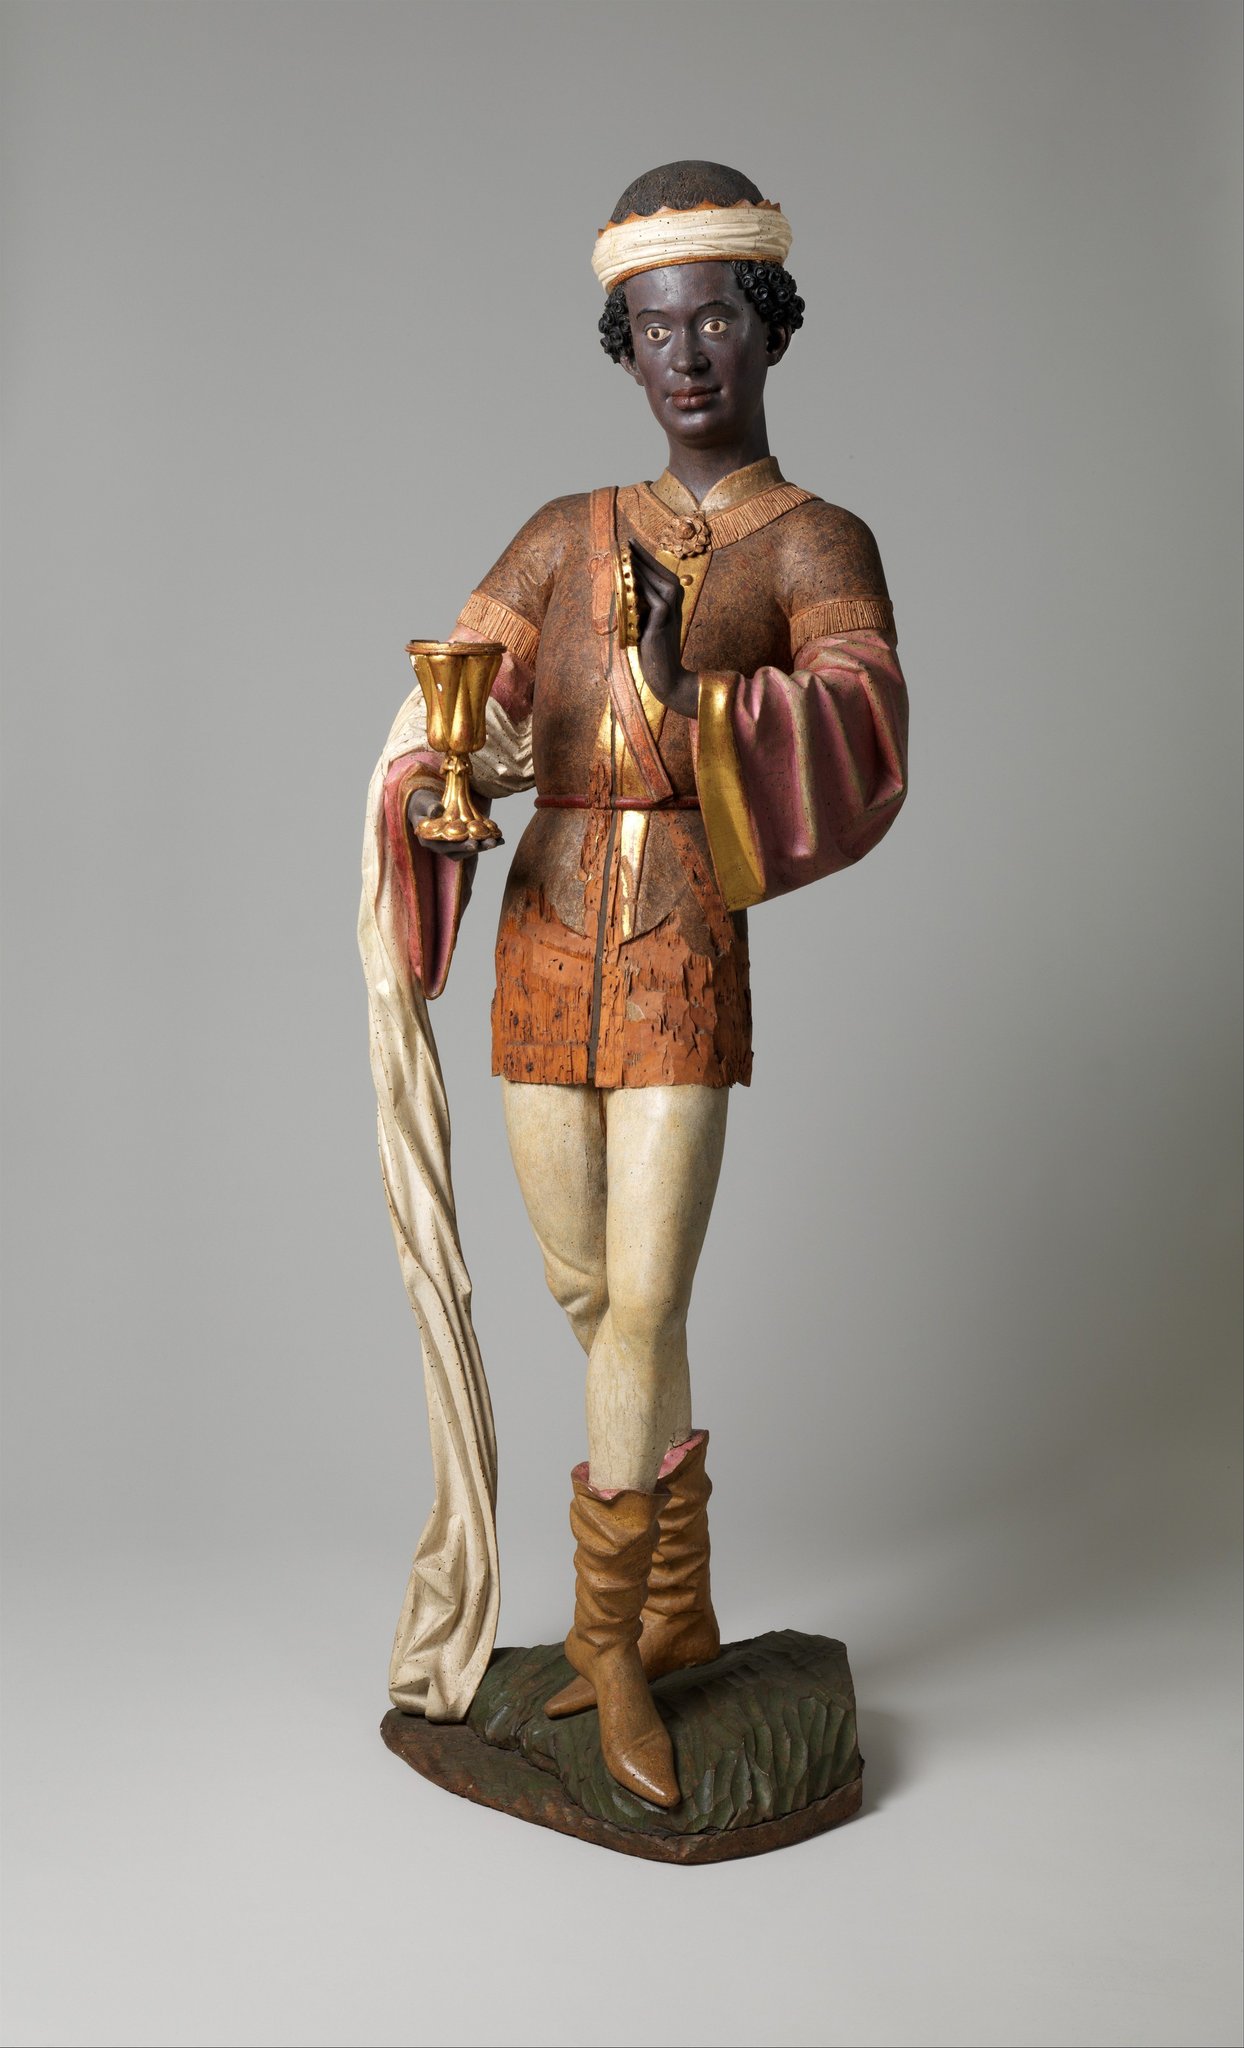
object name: statue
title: African Magus, one of the Three Kings from an Adoration Group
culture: german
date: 1489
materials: gilt, wood, paint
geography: germany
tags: kings,men